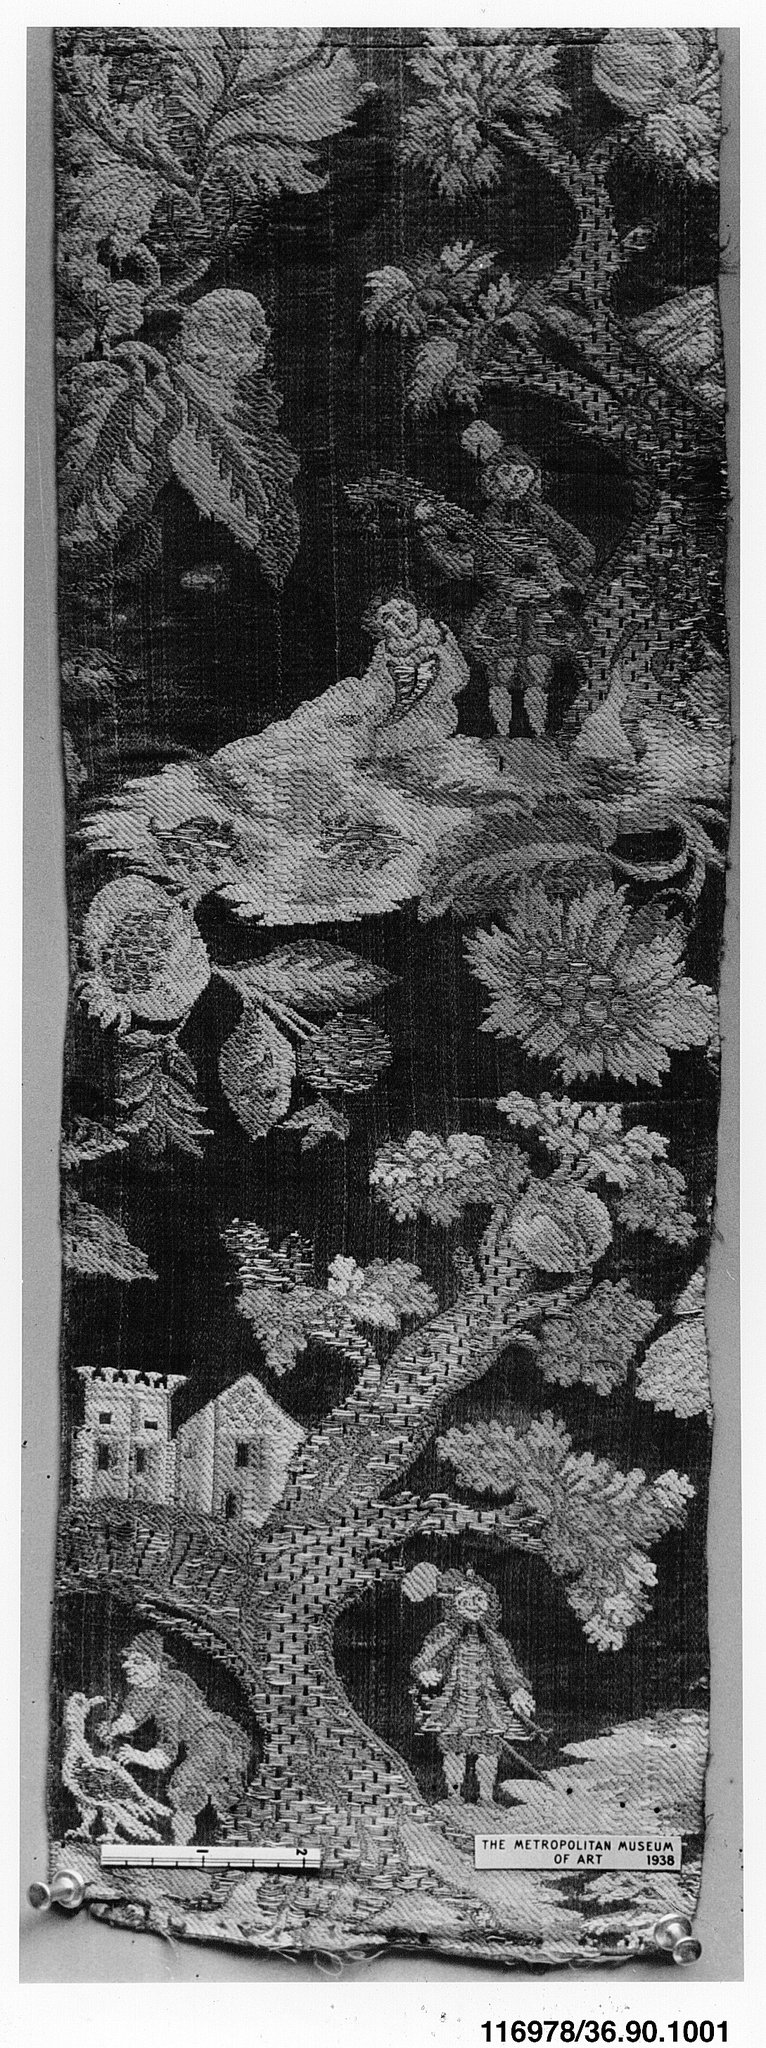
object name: piece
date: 1735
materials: metal thread, silk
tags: human figures,houses,flowers,trees